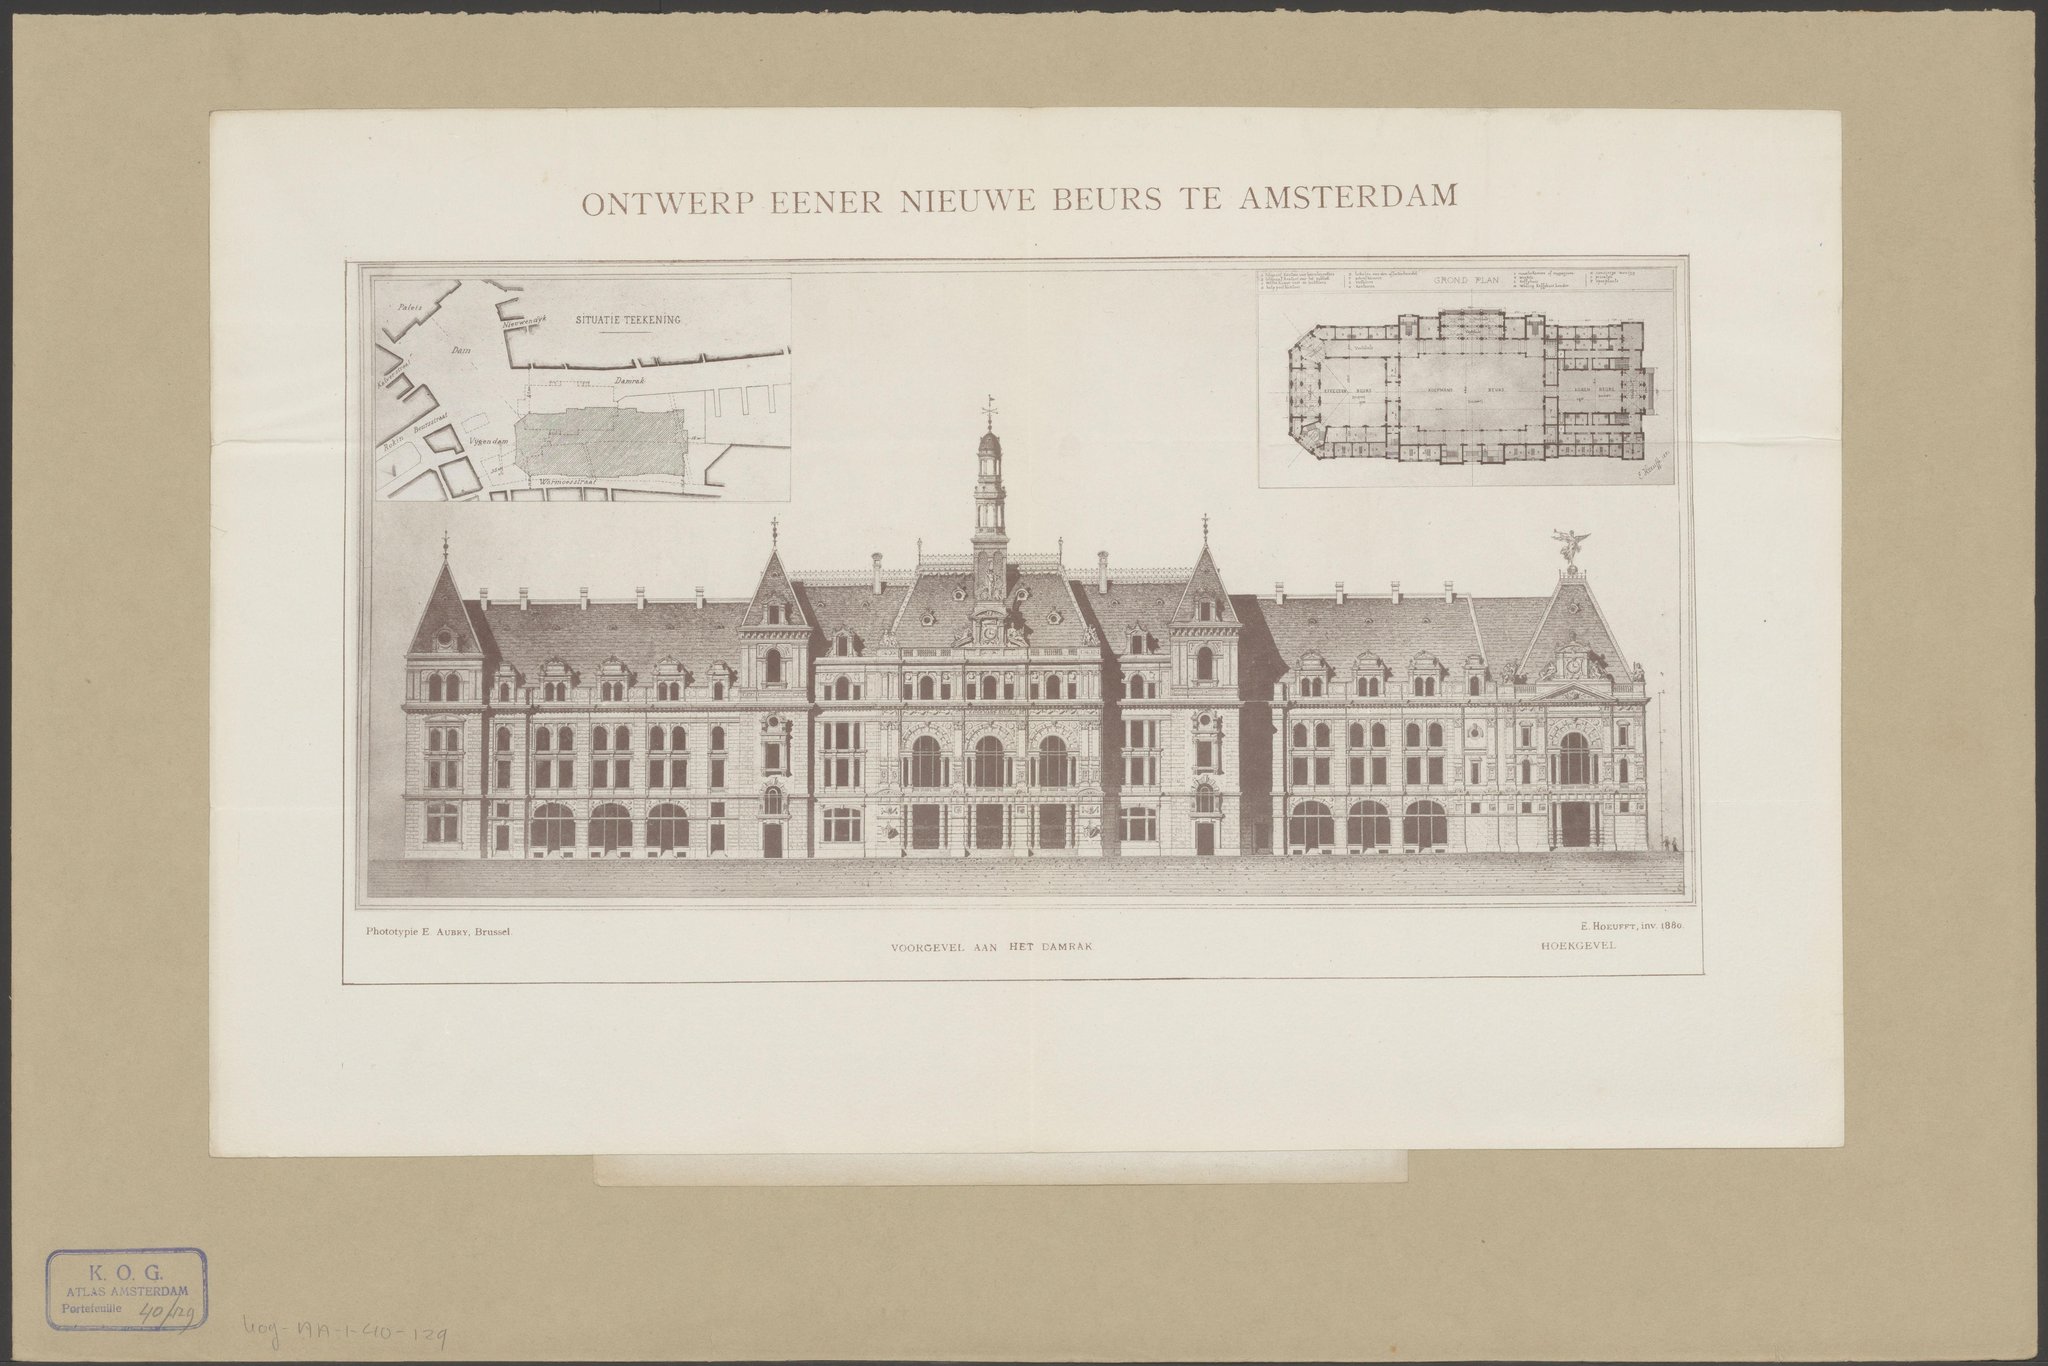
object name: photomechanical print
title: Ontwerp voor de voorgevel voor een nieuwe beurs te Amsterdam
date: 1881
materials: paper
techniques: photolithography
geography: haarlem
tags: jonkheer jacob pompejus ernst hoeufft van velsen en santpoort (1842-1910), stock exchange, stock-market, amsterdam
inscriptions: collector's mark: Lugt 1641b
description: Ontwerp voor een nieuwe beurs te Amsterdam. Dit ontwerp is van E. Hoeufft. Onderwerpsrubriek binnen de Atlas Amsterdam: Handel en Zeevaart, D. Beurs-Ontwerpen.